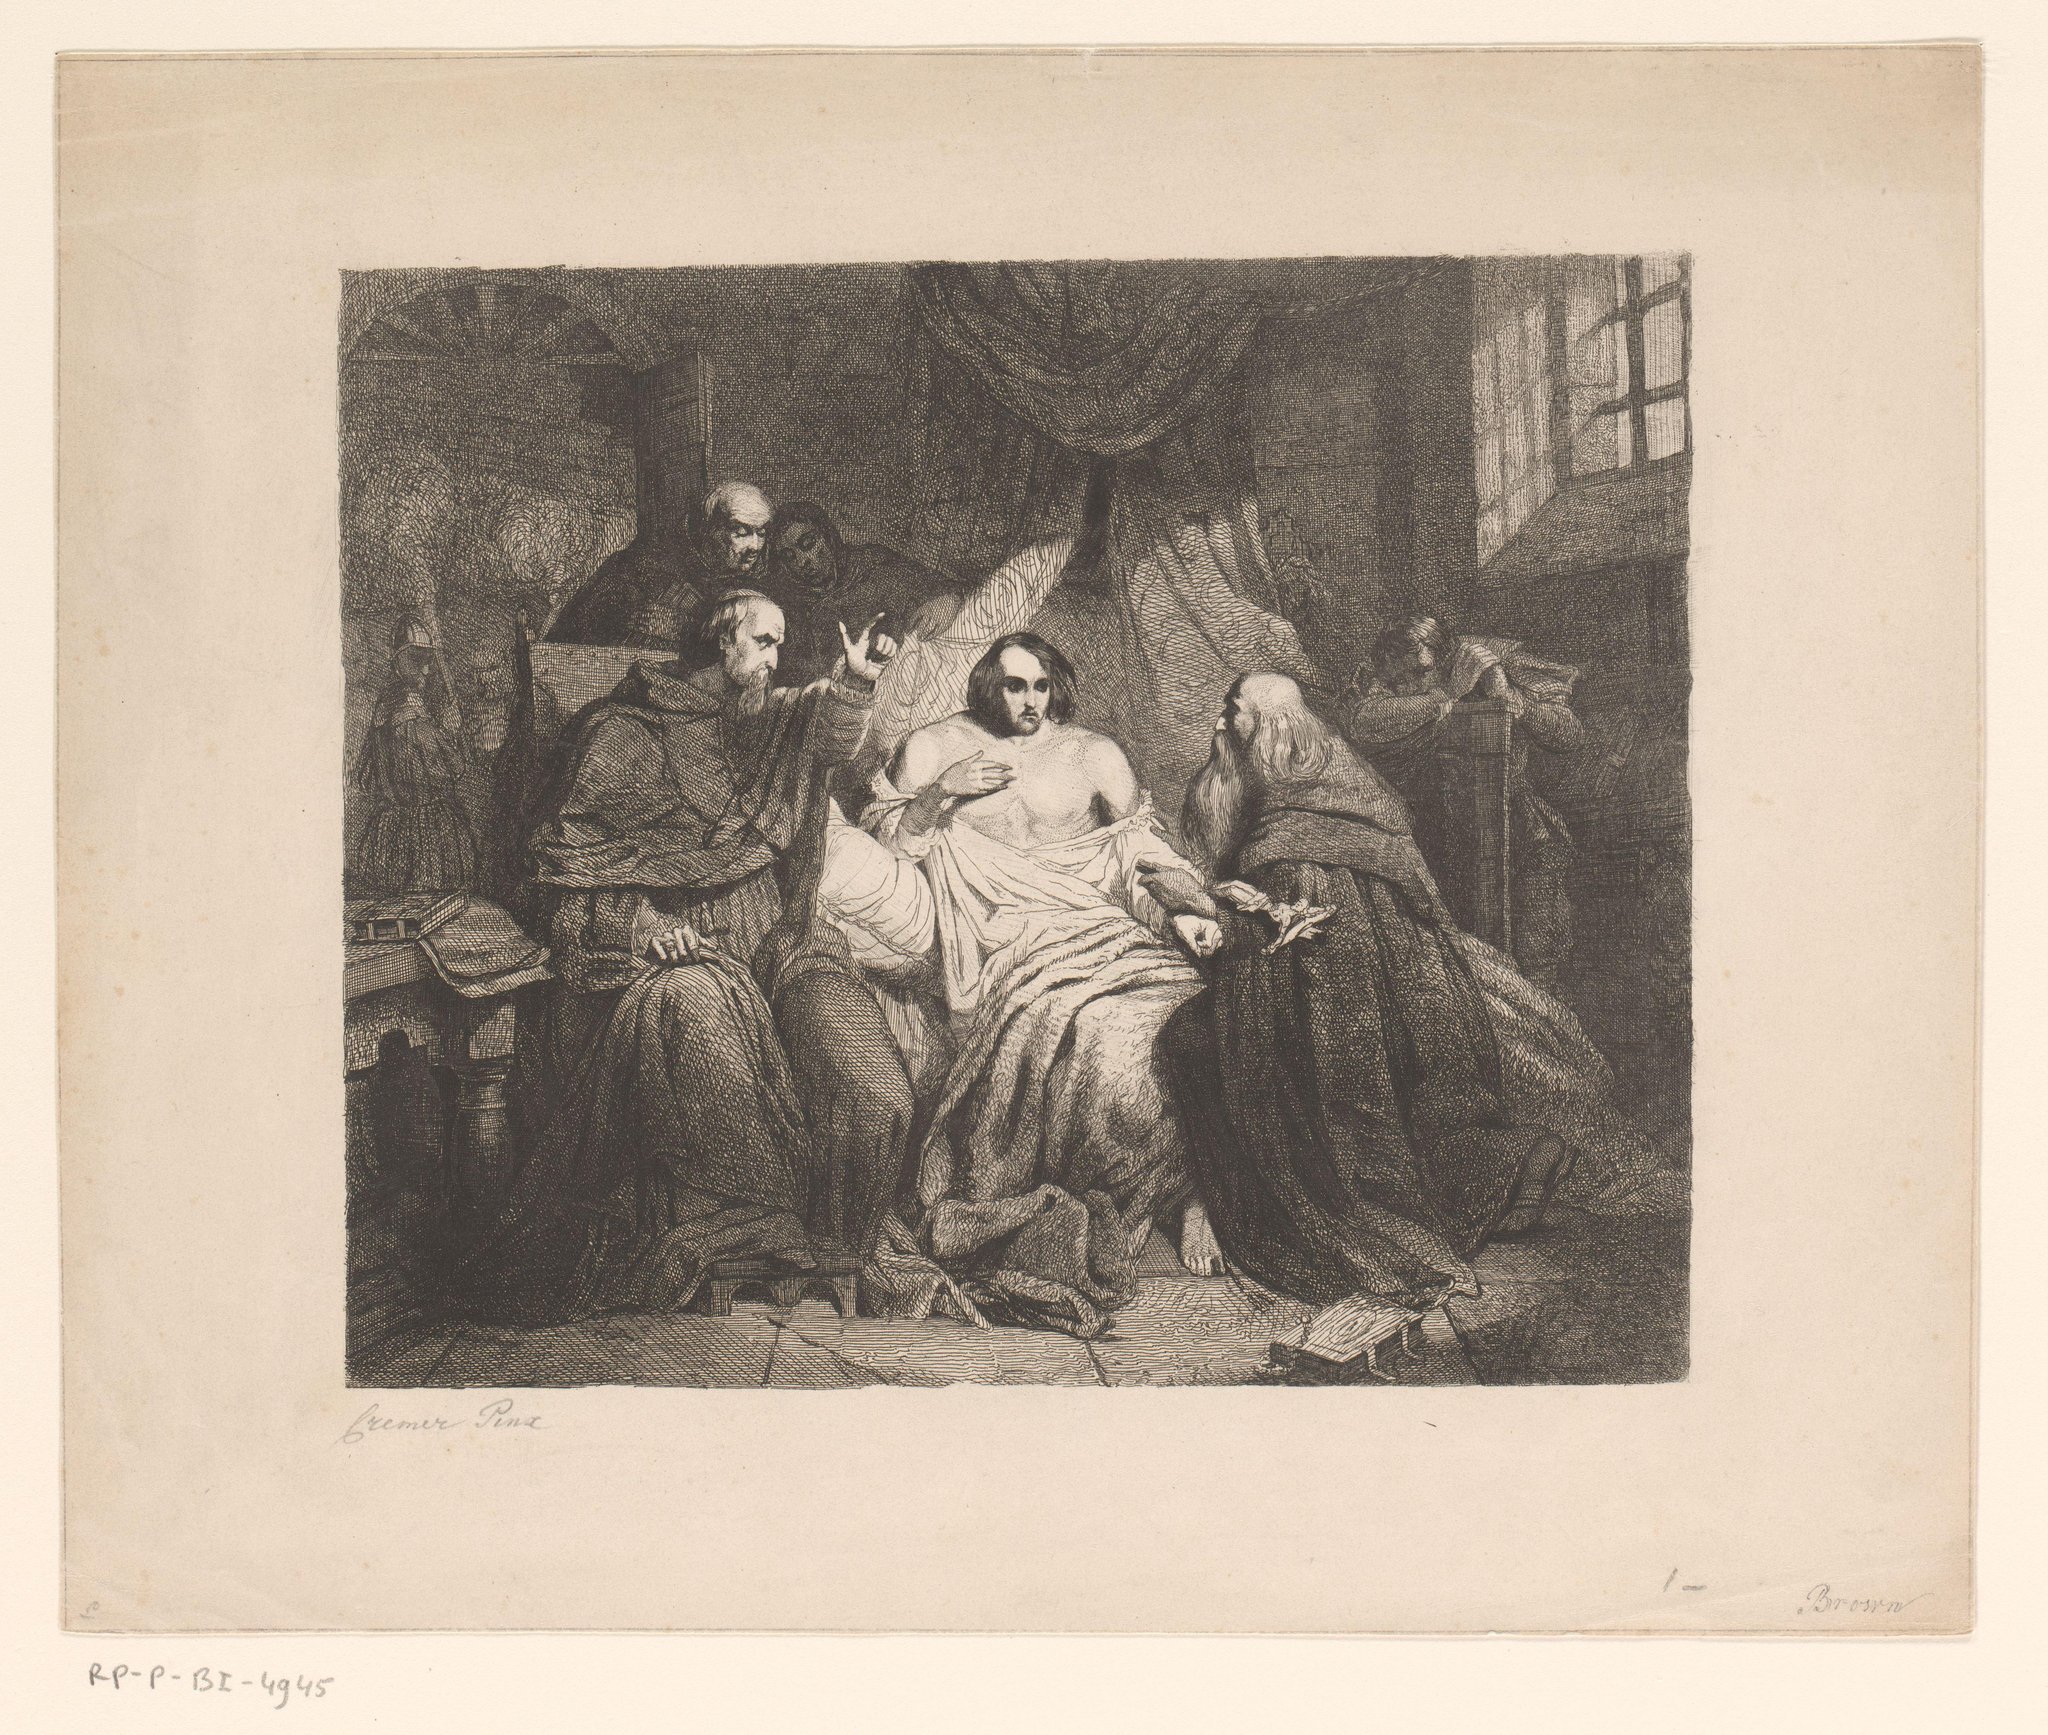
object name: print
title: Ondervraging van Don Carlos door de grootinquisiteur Torquemada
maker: henry brown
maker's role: print maker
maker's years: 1816-1870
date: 1840-1870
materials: paper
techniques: etching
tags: asking, question, interrogation, inquisitor, interior ~ representation of a building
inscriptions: collector's mark: Lugt 2228